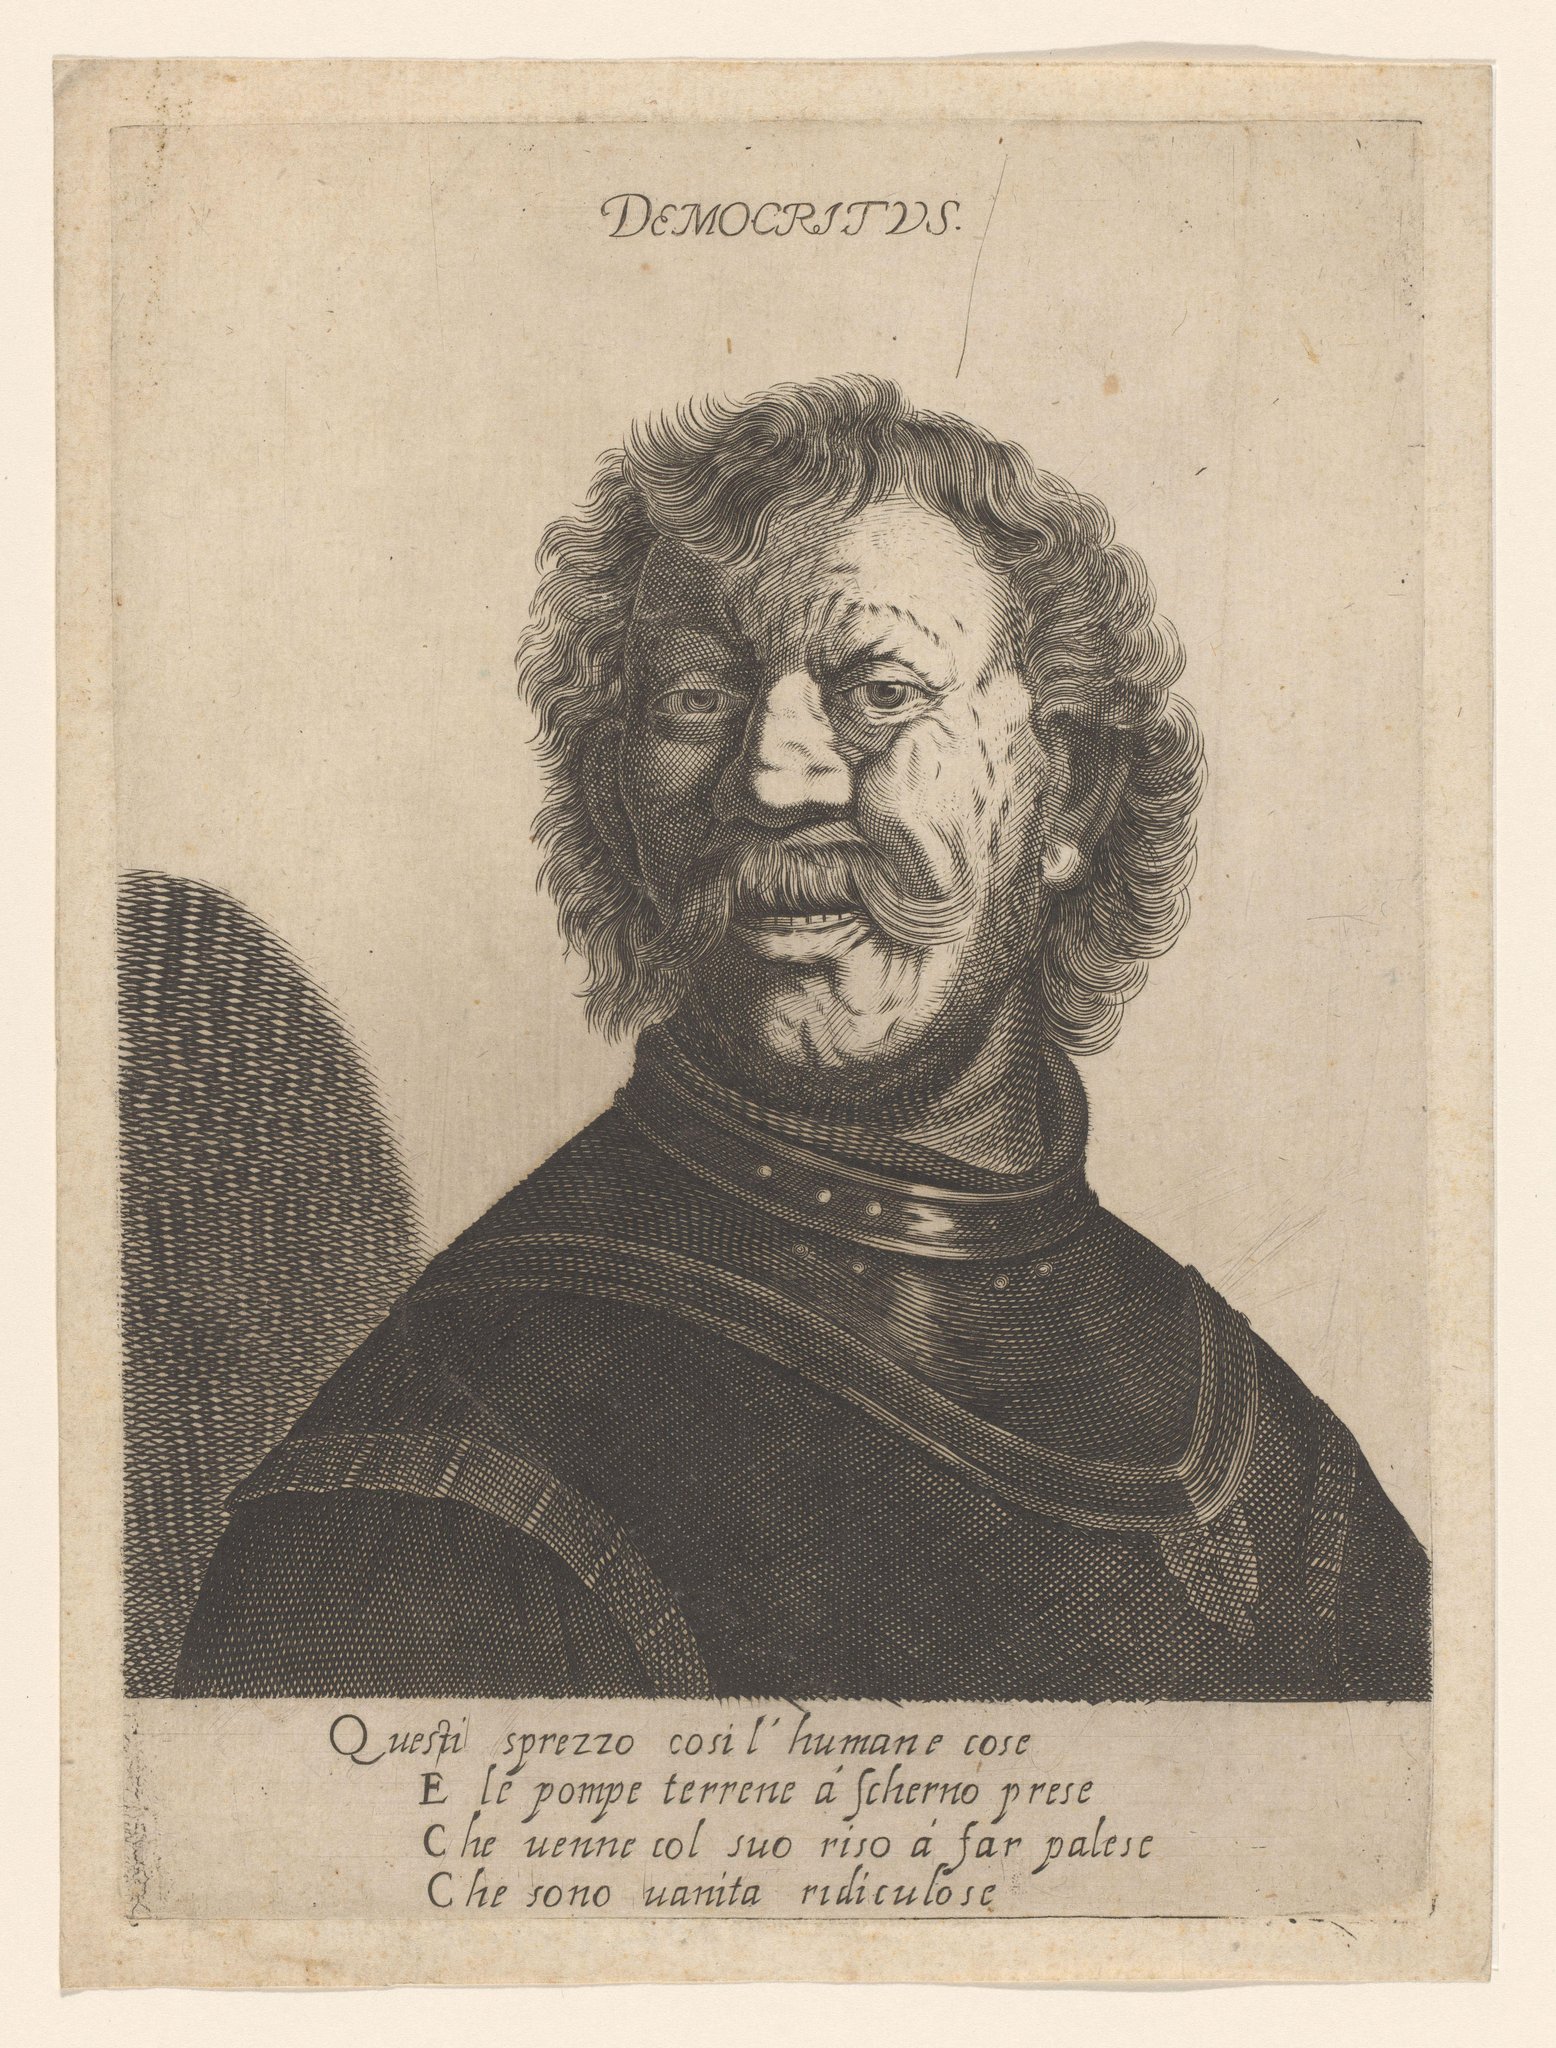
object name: print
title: Democritus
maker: Anonymous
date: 1636-1660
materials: paper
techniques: engraving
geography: netherlands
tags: laughing, (story of) democritus, the philosopher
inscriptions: collector's mark: Lugt 2760, collector's mark: Lugt 2228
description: Grove Italiaanse kopie in dezelfde richting van de ets van Jan Gillisz. van Vliet naar Rembrandt: Lachende man met halsstuk. Het opschrift karakteriseert de figuur als de lachende filosoof Democritus. De identificatie wordt verder toegelicht in het vierregelige Italiaanse onderschrift.